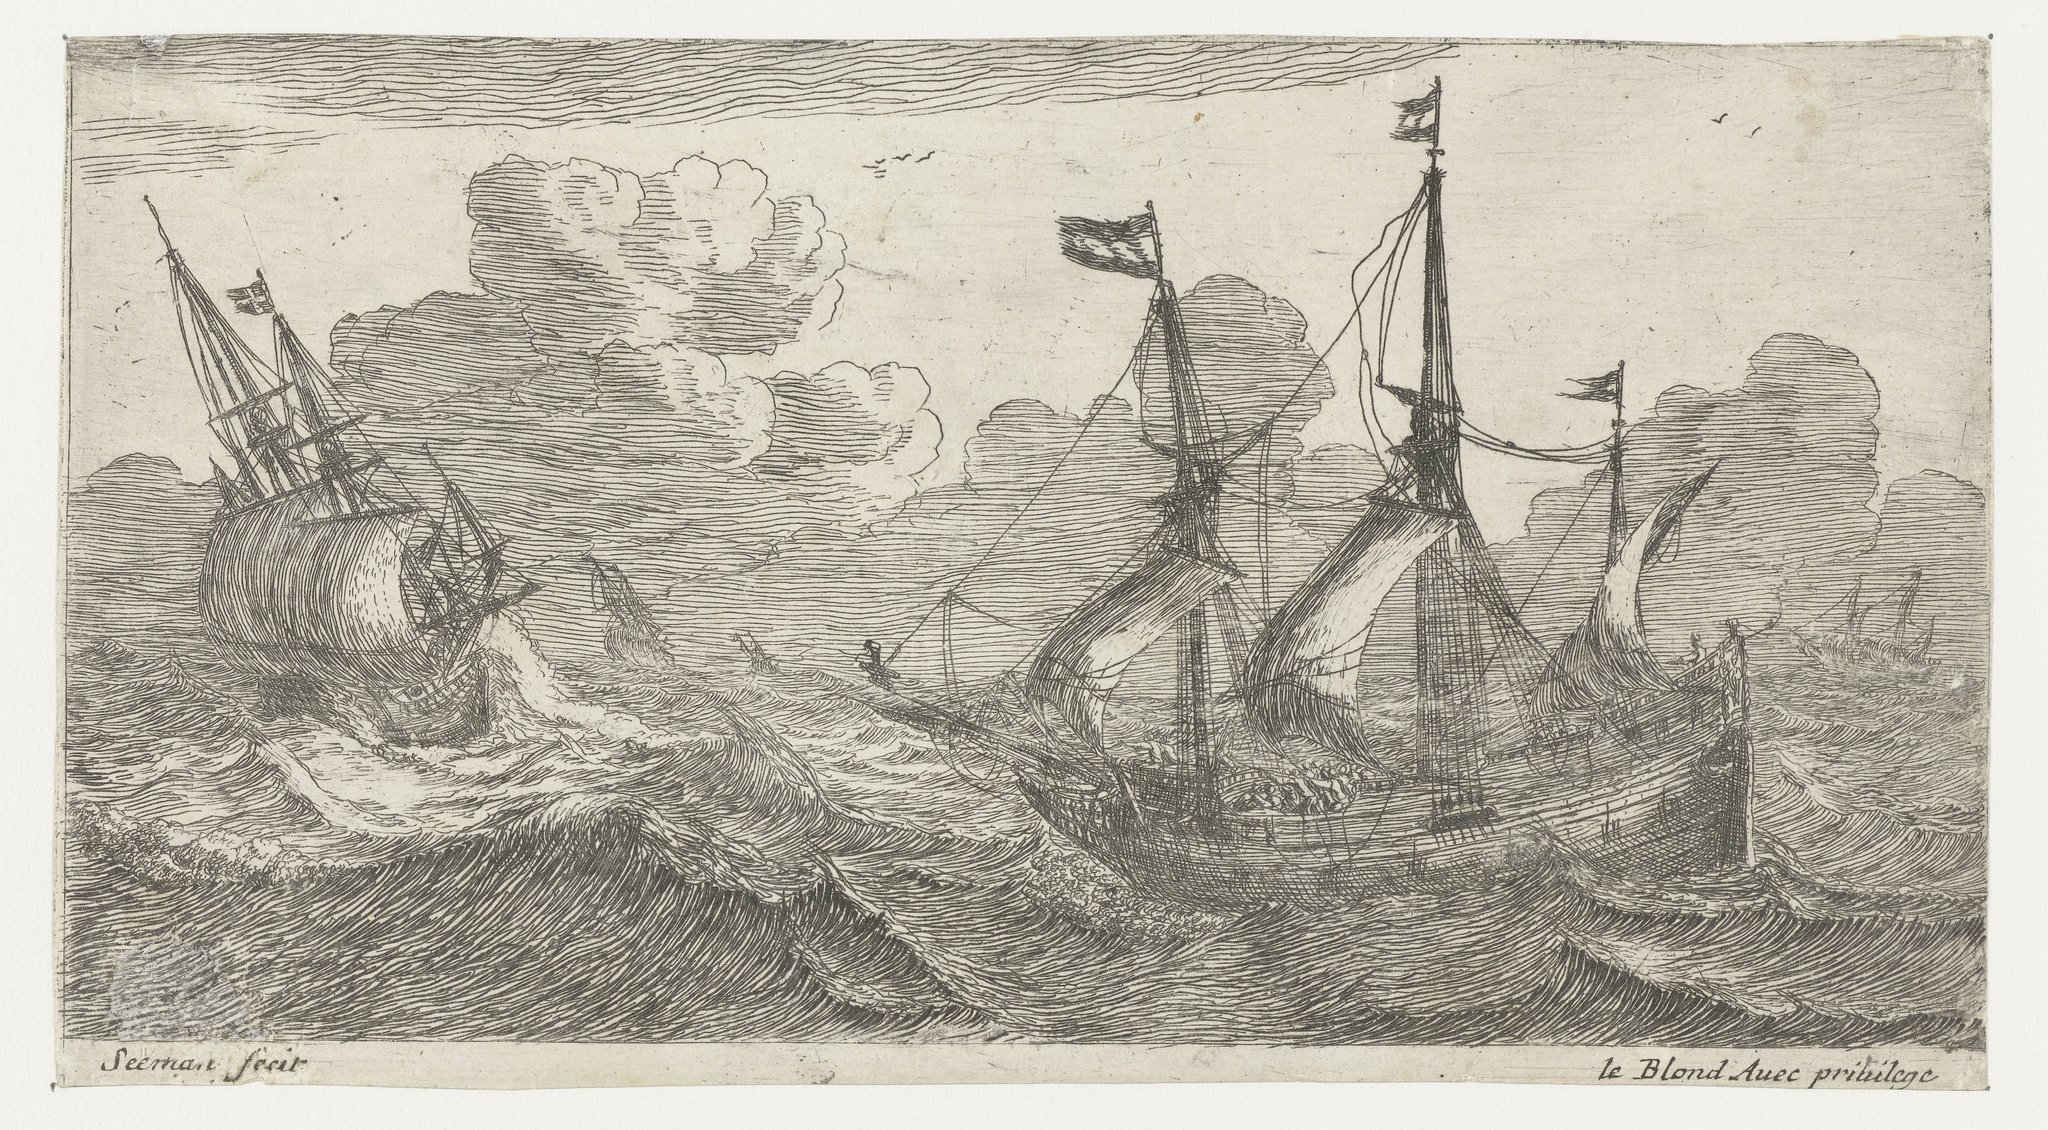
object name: print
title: Zeilschepen op ruige zee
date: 1650-1709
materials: paper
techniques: etching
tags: sailing-ship, sailing-boat, storm at sea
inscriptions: collector's mark: Lugt 2228a